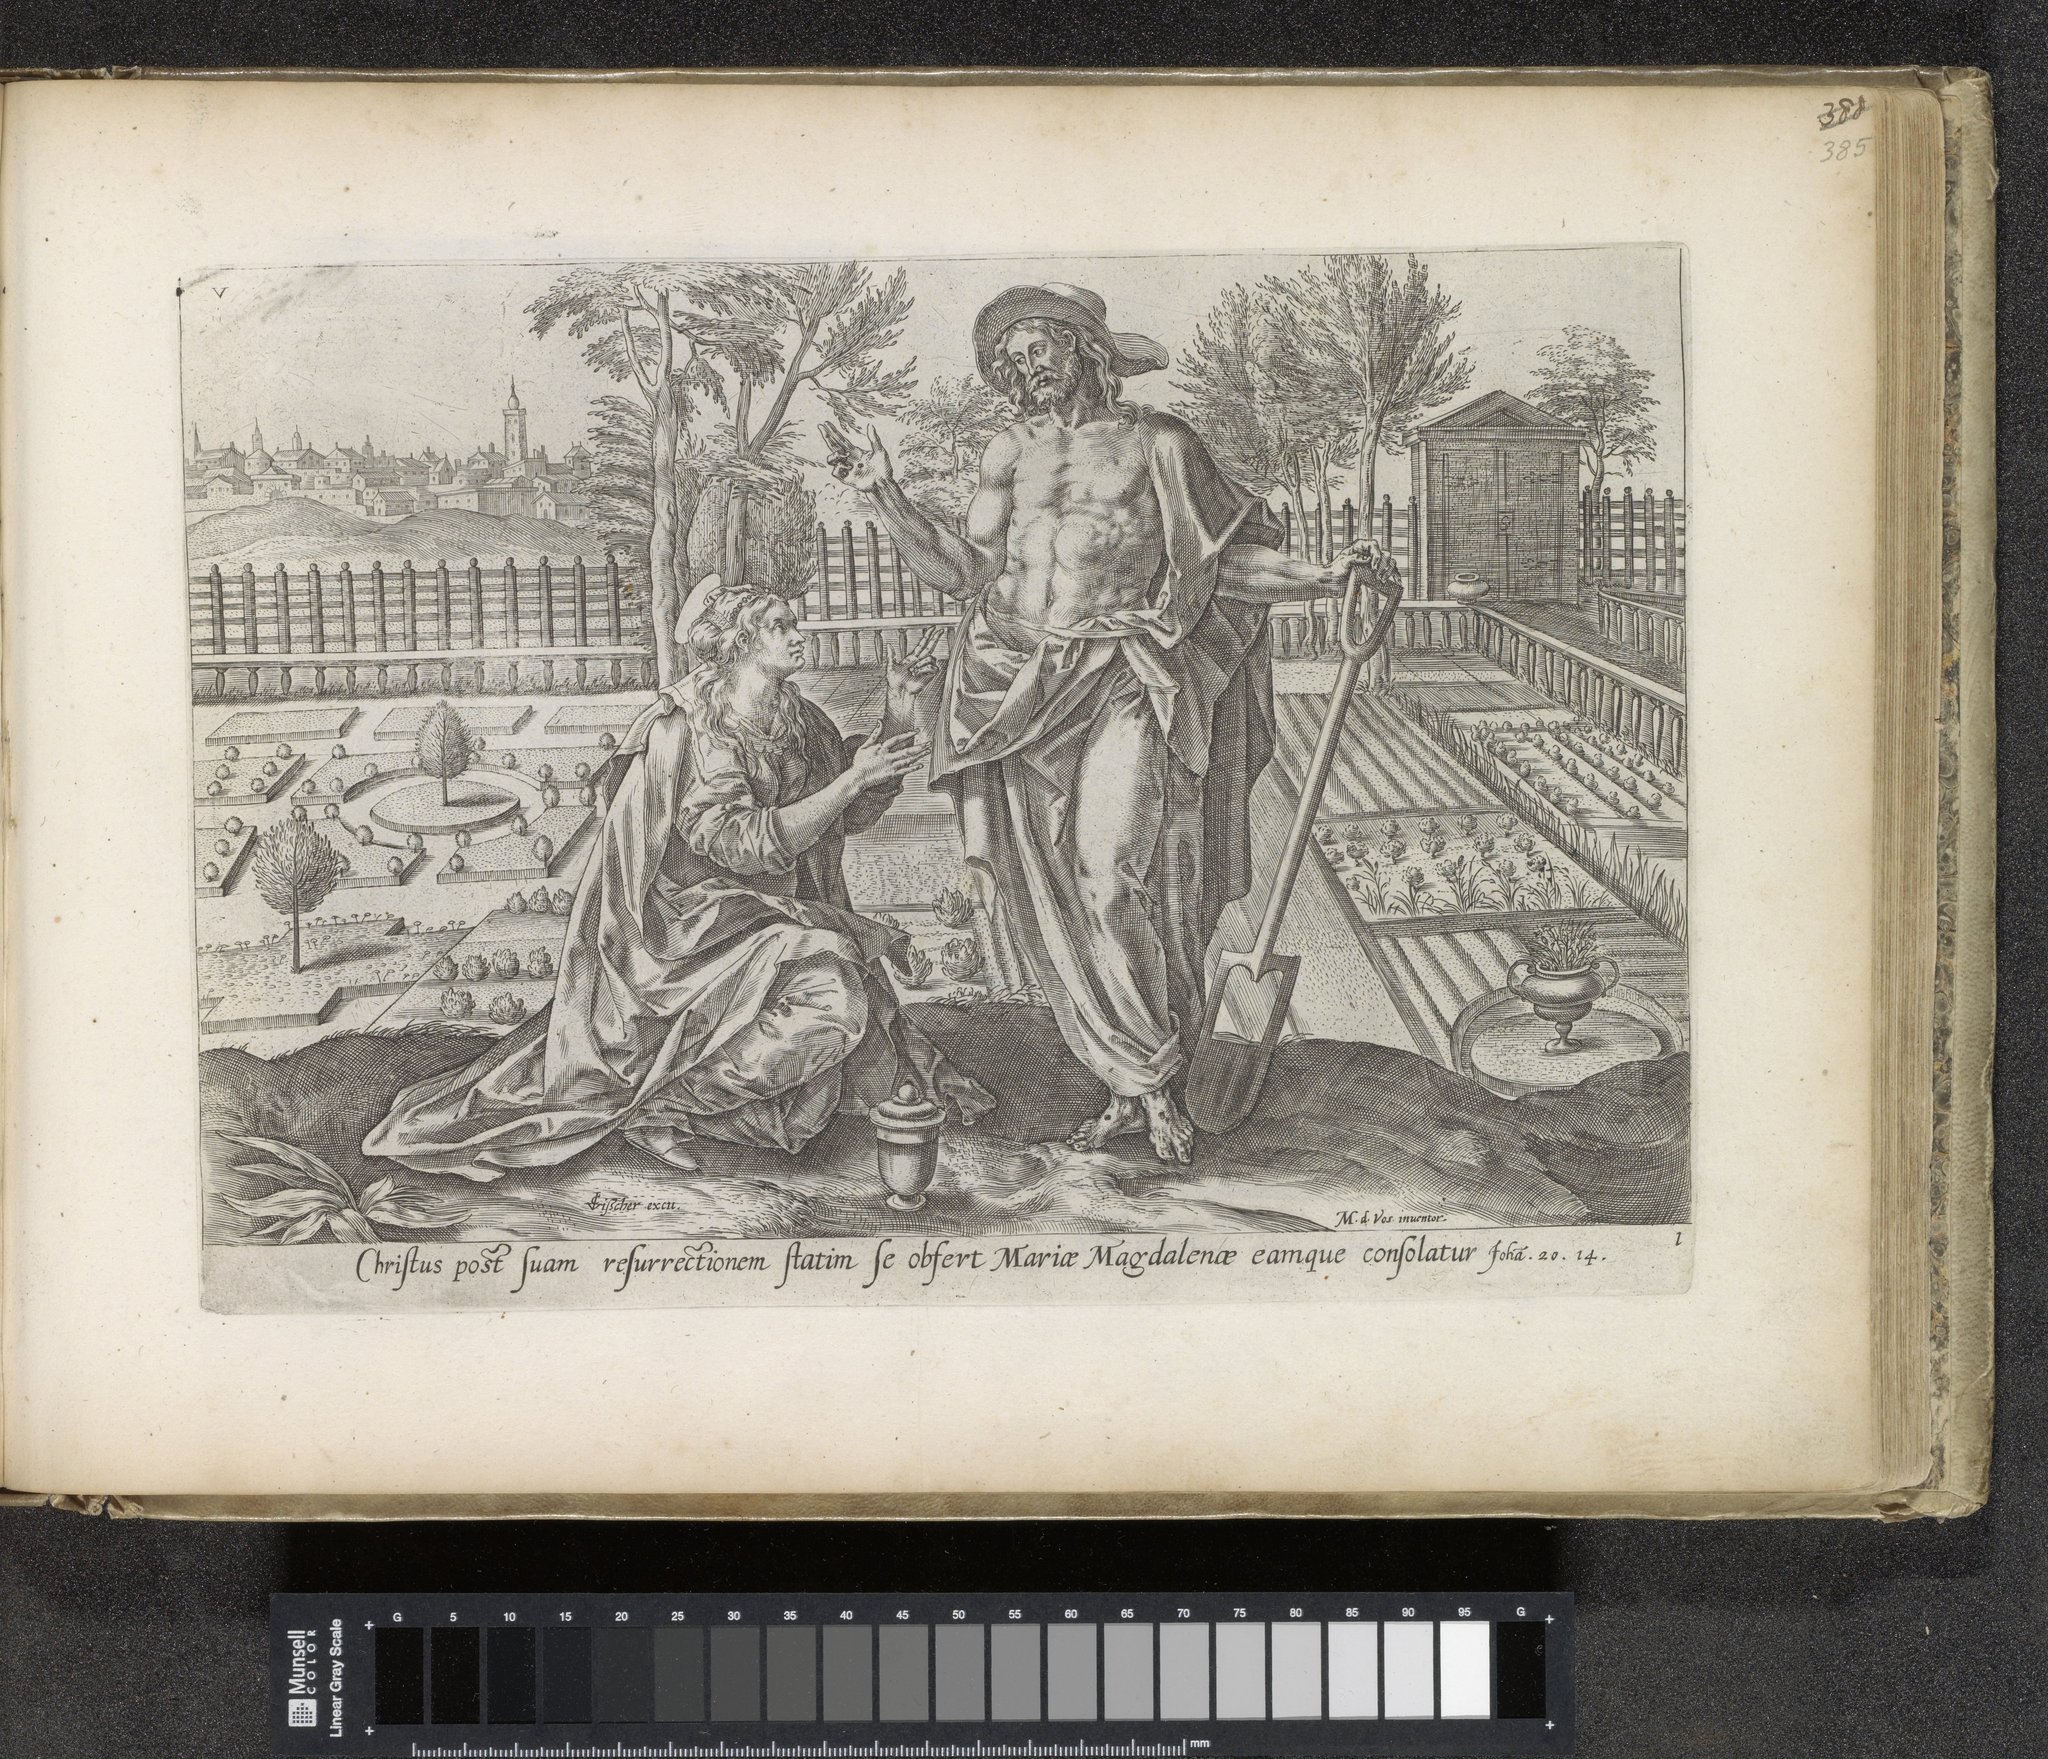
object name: print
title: Verschijningen van de opgestane Christus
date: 1585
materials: paper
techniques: engraving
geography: amsterdam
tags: mary magdalene kneeling before christ, who is usually represented as a gardener with a hoe and/or a spade; 'noli me tangere'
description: Maria Magdalena herkent de opgestane Christus, nadat ze hem voor tuinman had aangezien, en knielt voor hem. Christus is gekleed als tuinman. Hij zegt haar hem niet vast te houden. Onder de voorstelling een verwijzing in het Latijn naar de Bijbeltekst in Joh. 20:14. Deze prent maakt deel uit van een album.